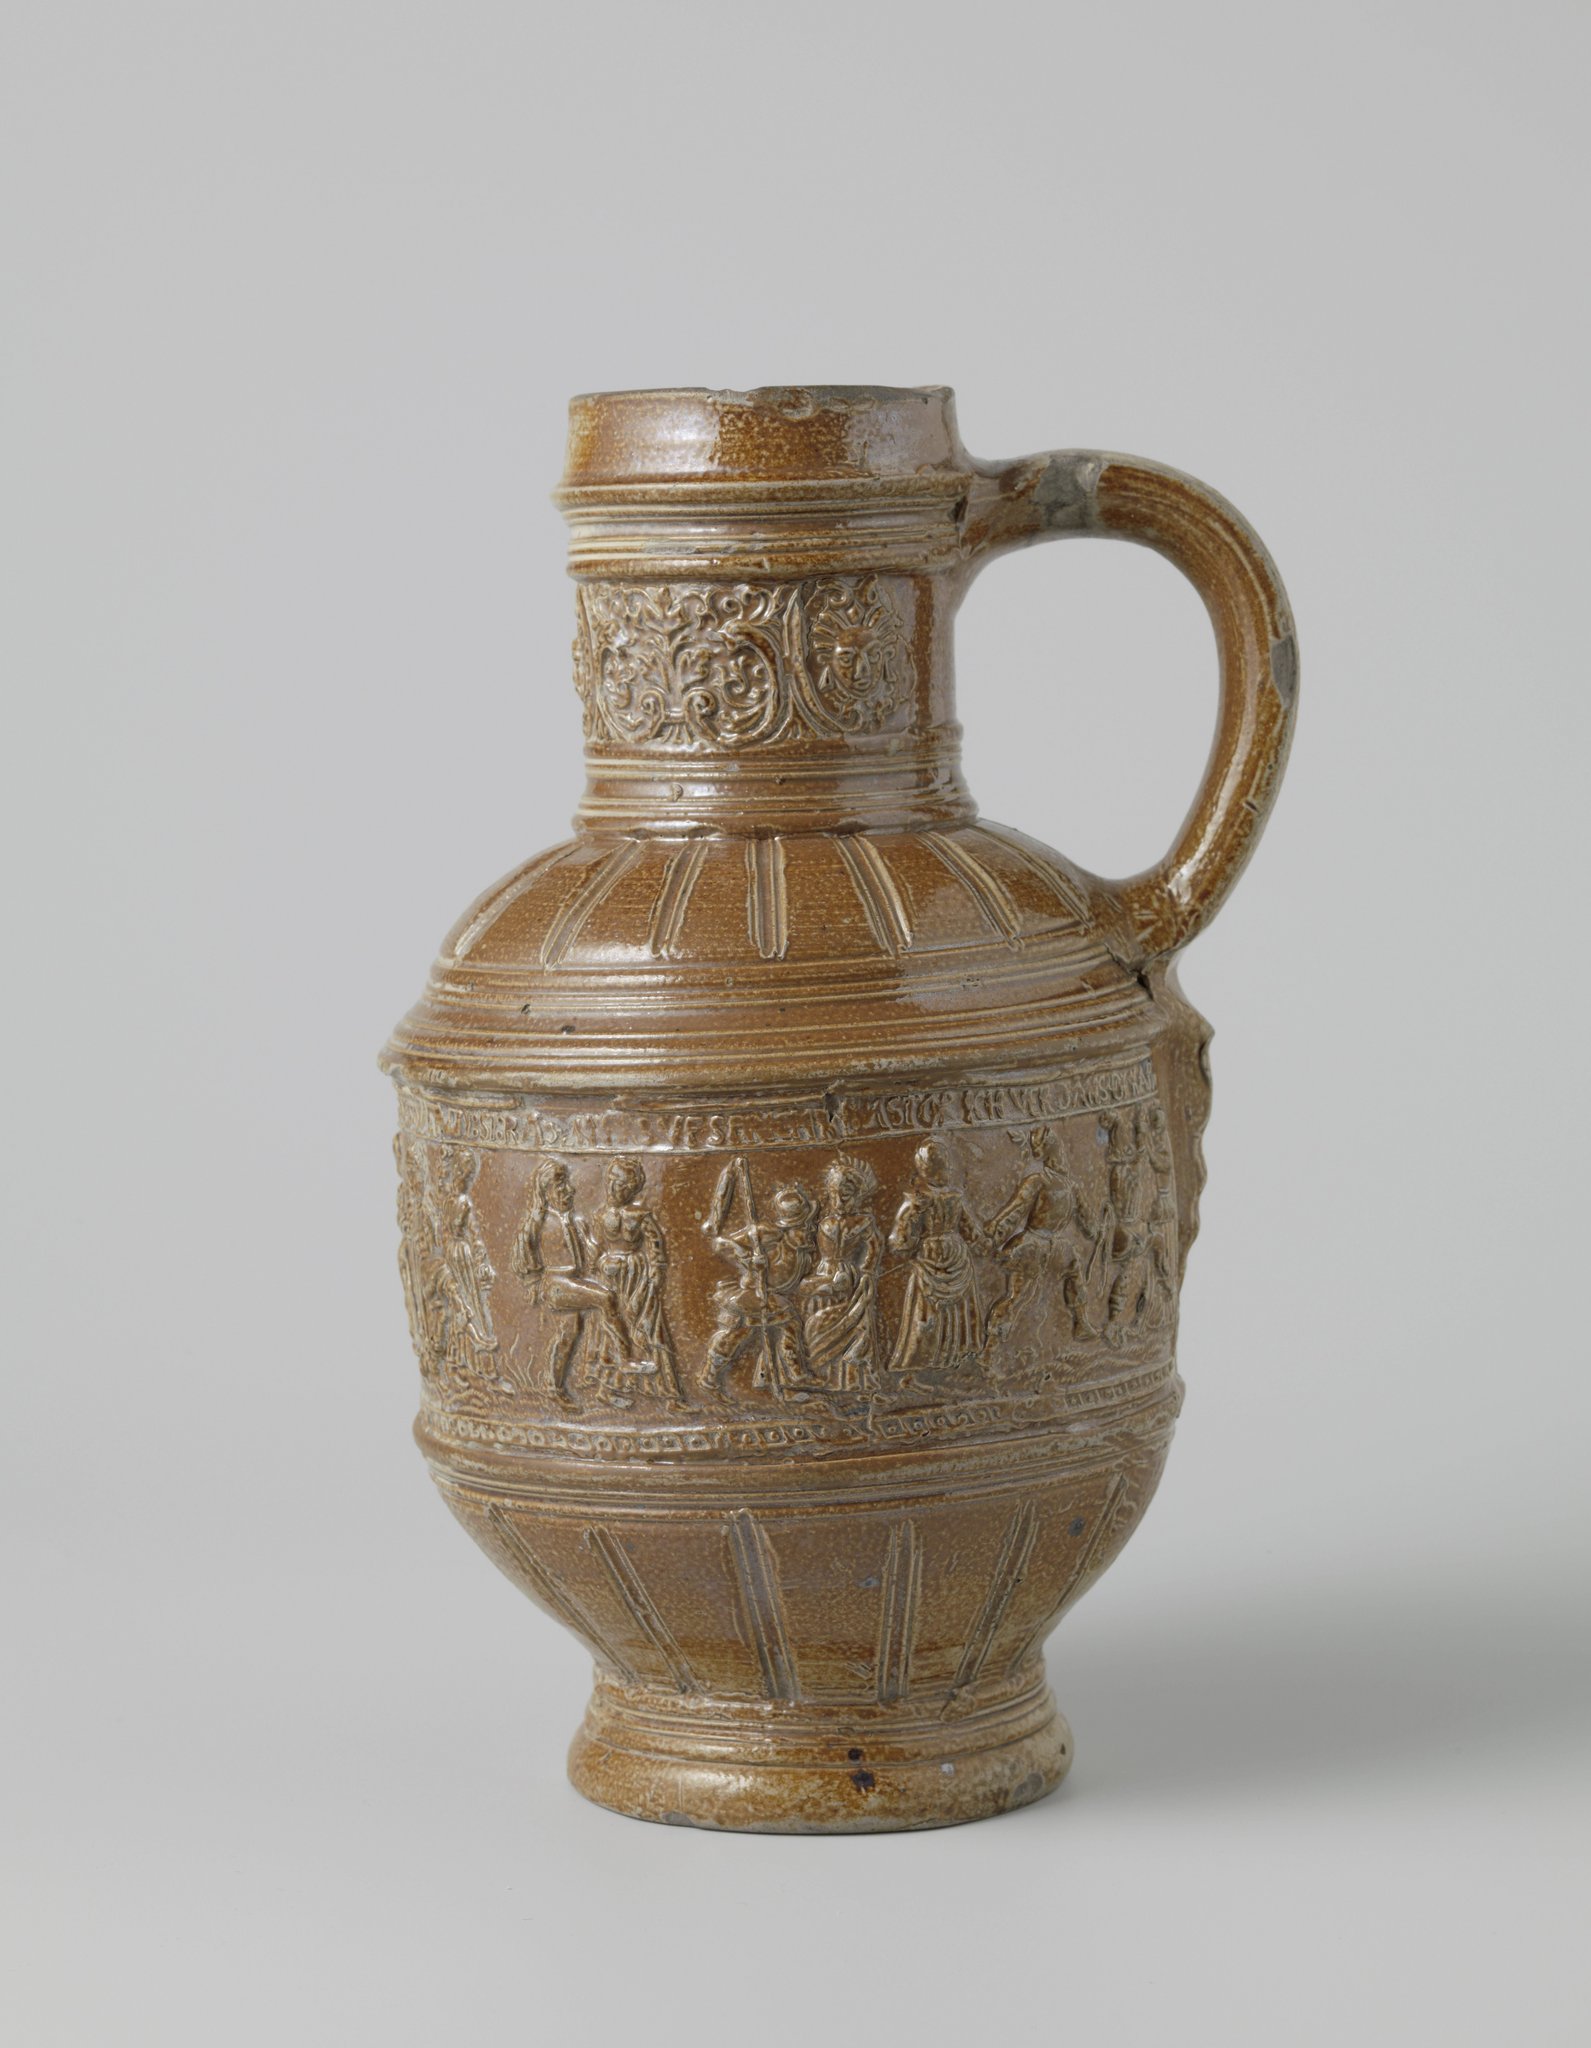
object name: jug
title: Jug with a dancing couple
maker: Anonymous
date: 1580-1600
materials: engobe, glaze, stoneware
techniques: firing, forming, relief, turning, vitrification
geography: raeren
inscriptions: inscription: ‘GERHET DV MVS DAPER BLASEN SO DANSSEN DEI BVREN ALS WEREN SI RASEN FRS VF SPRICHT BASTOR ICH VER DANS DY KAPA KO[...]’, mark: ‘W.Z.’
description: Kruik van steengoed op hoge voet met een cilindrisch lichaam, ronde schouder en wijde nek. Profielen op de nek, het lichaam en de voet. Bedekt met een bruine engobe. Op de buik in reliëf een gedrukte en opgelegde band met een boerendans. Links zijn de muzikanten afgebeeld met daarnaast het dansende paar. In het tweede vak van links de datum '1597'. Onder de band het opschrift 'GERHET DV MVS DAPER BLASEN SO DANSSEN DEI BVREN ALS WEREN SI RASEN FRS VF SPRICHT BASTOR ICH VER DANS DY KAPA KO[...]'. Tussen de muzikanten en het eerste paar het merk 'W.Z.'. Het onderste deel van de buik loopt schuin af naar de voet en heeft, net als de schouder, ingegrifte vakken. Op de nek een band in reliëf met vazen met bloemranken onderbroken door maskers in medaillons. Raeren.